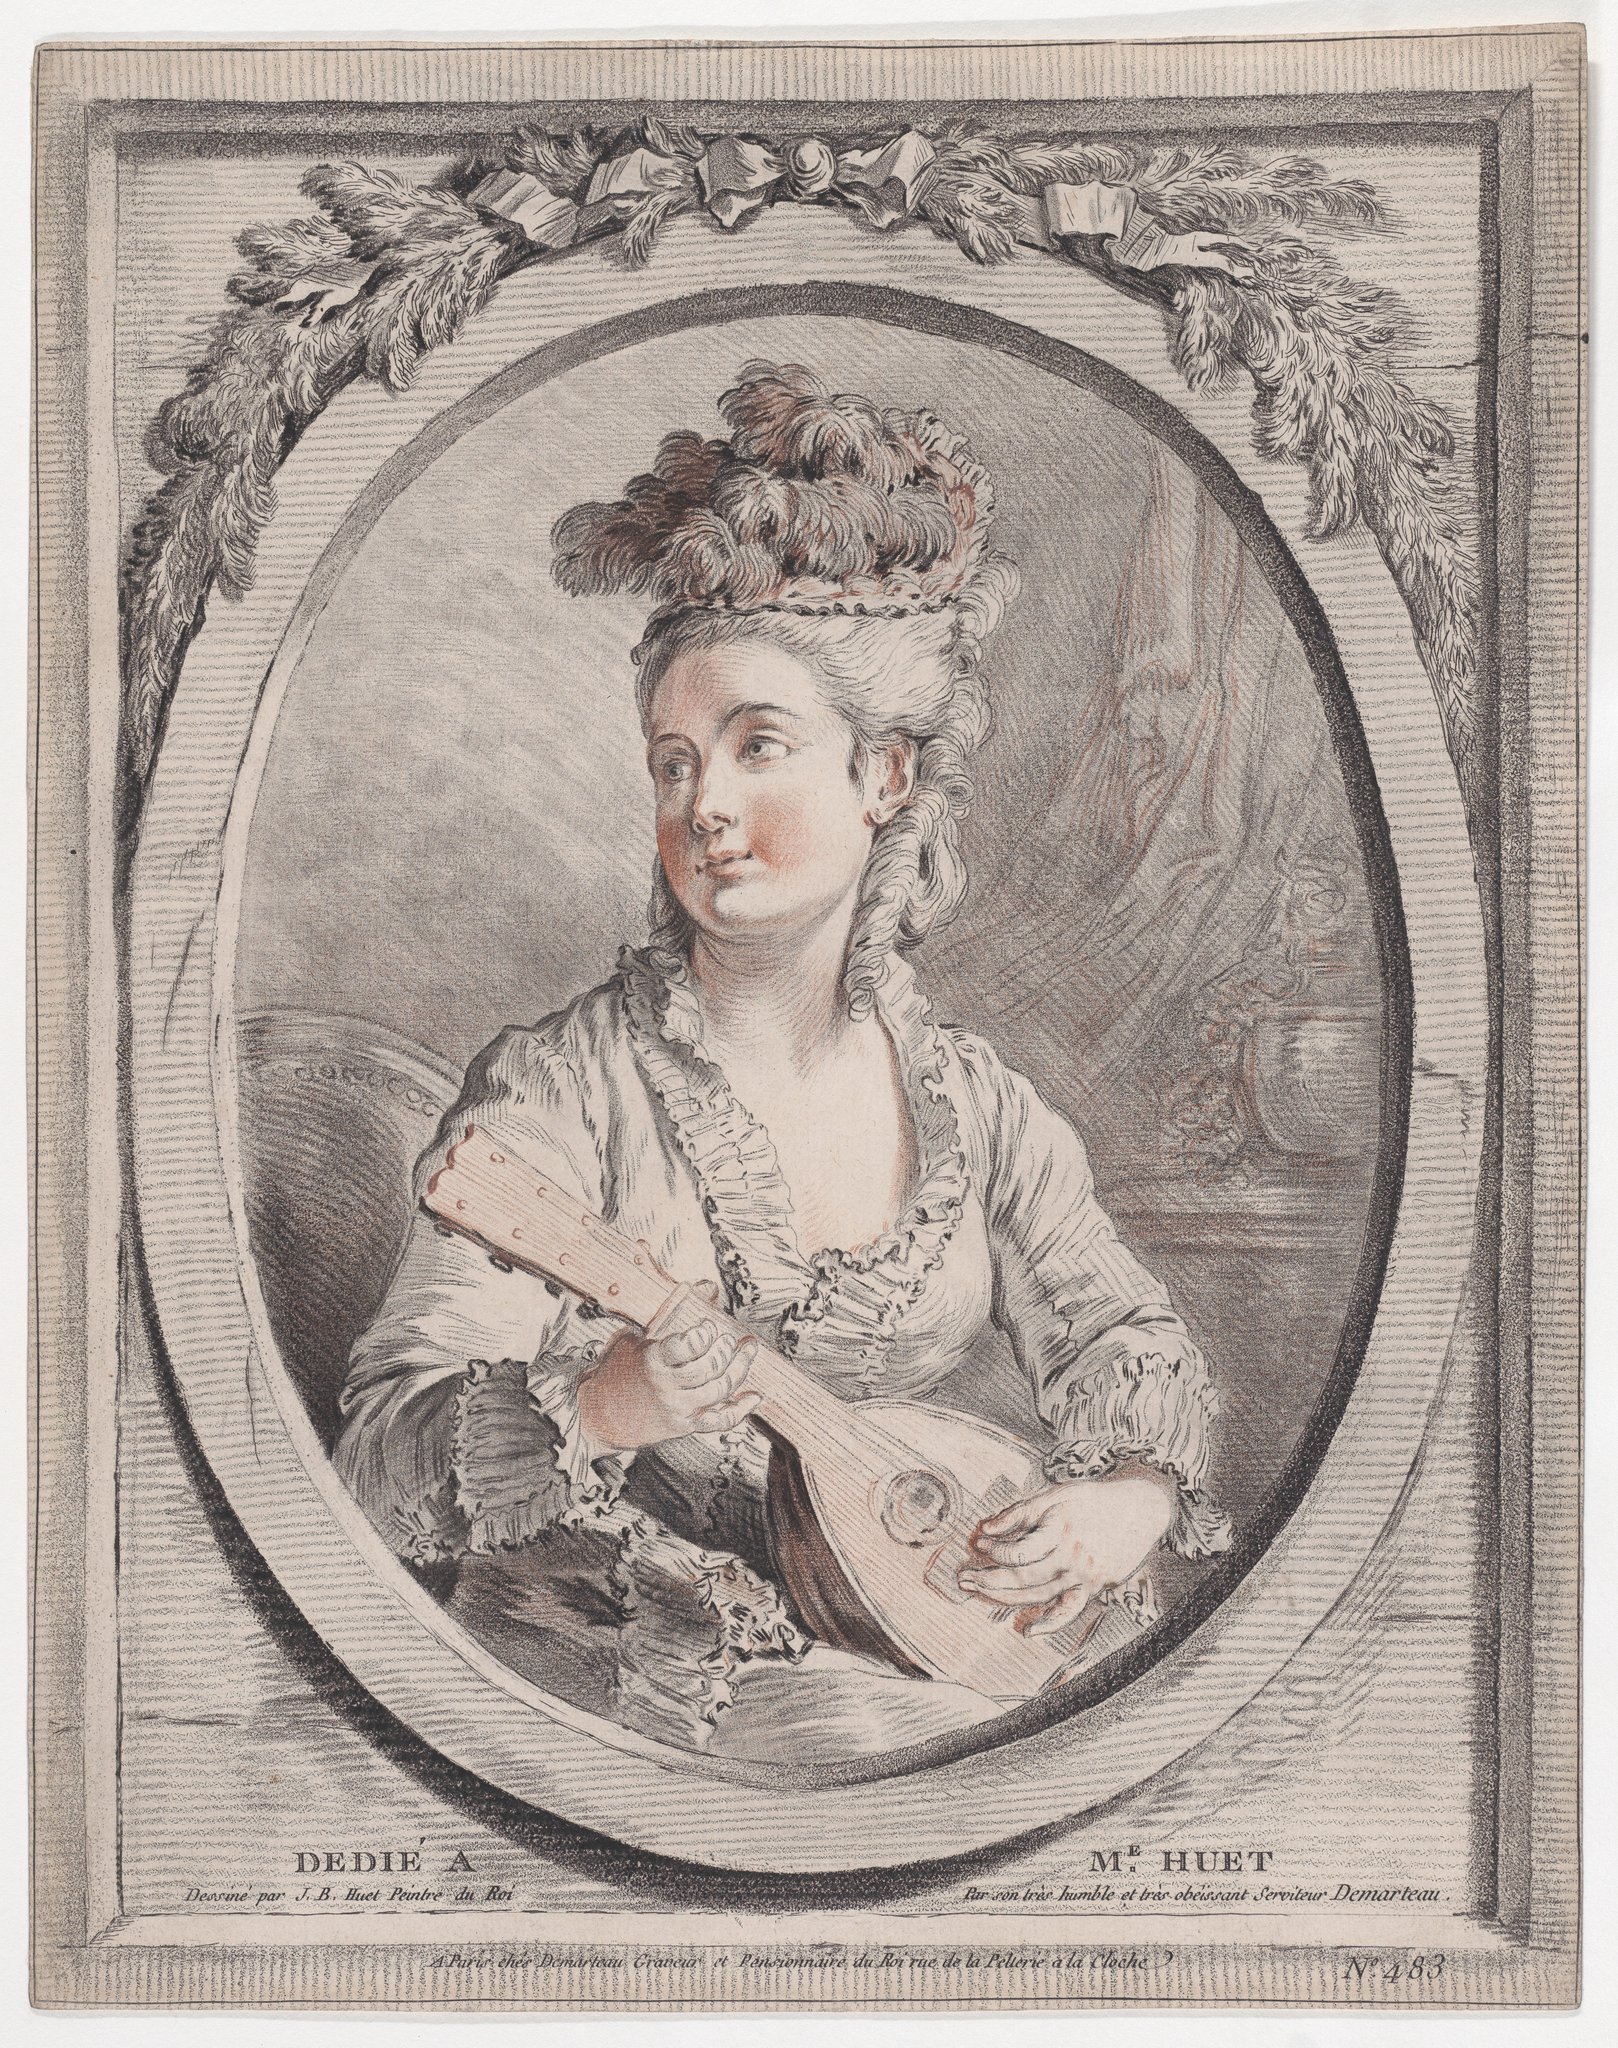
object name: print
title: Musicienne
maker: gilles demarteau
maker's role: artist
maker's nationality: french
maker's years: 1722-1776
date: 1773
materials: ink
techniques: printmaking, etching, printing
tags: musical instruments,women,musicians